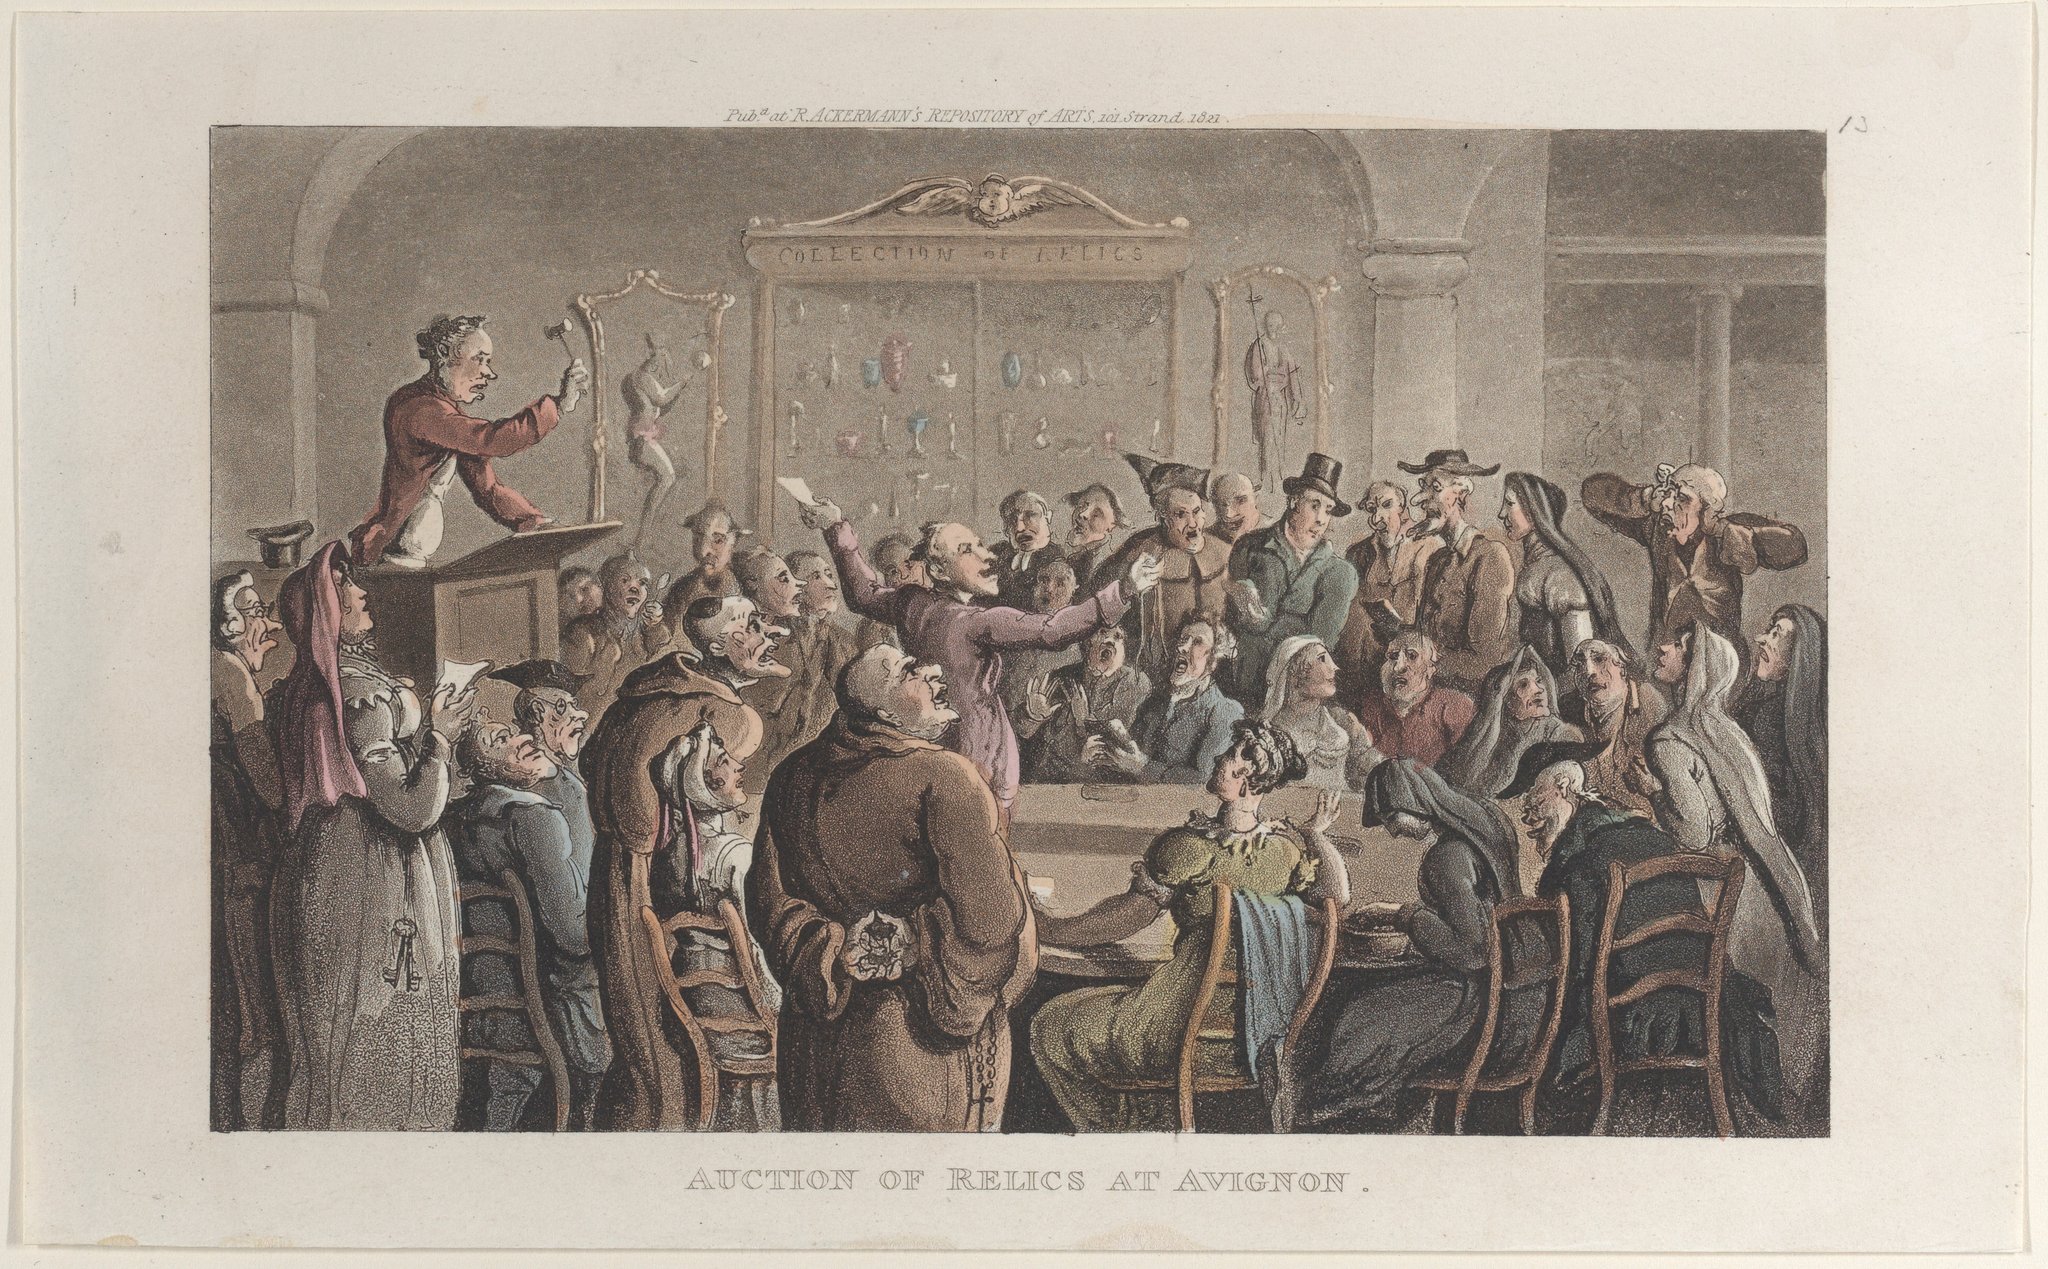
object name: print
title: Auction of Relics at Avignon, from "Journal of Sentimental Travels in the Southern Provinces of France, Shortly Before the Revolution"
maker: thomas rowlandson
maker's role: artist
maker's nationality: british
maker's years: 1757-1827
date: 1821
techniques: aquatint, etching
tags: men,women